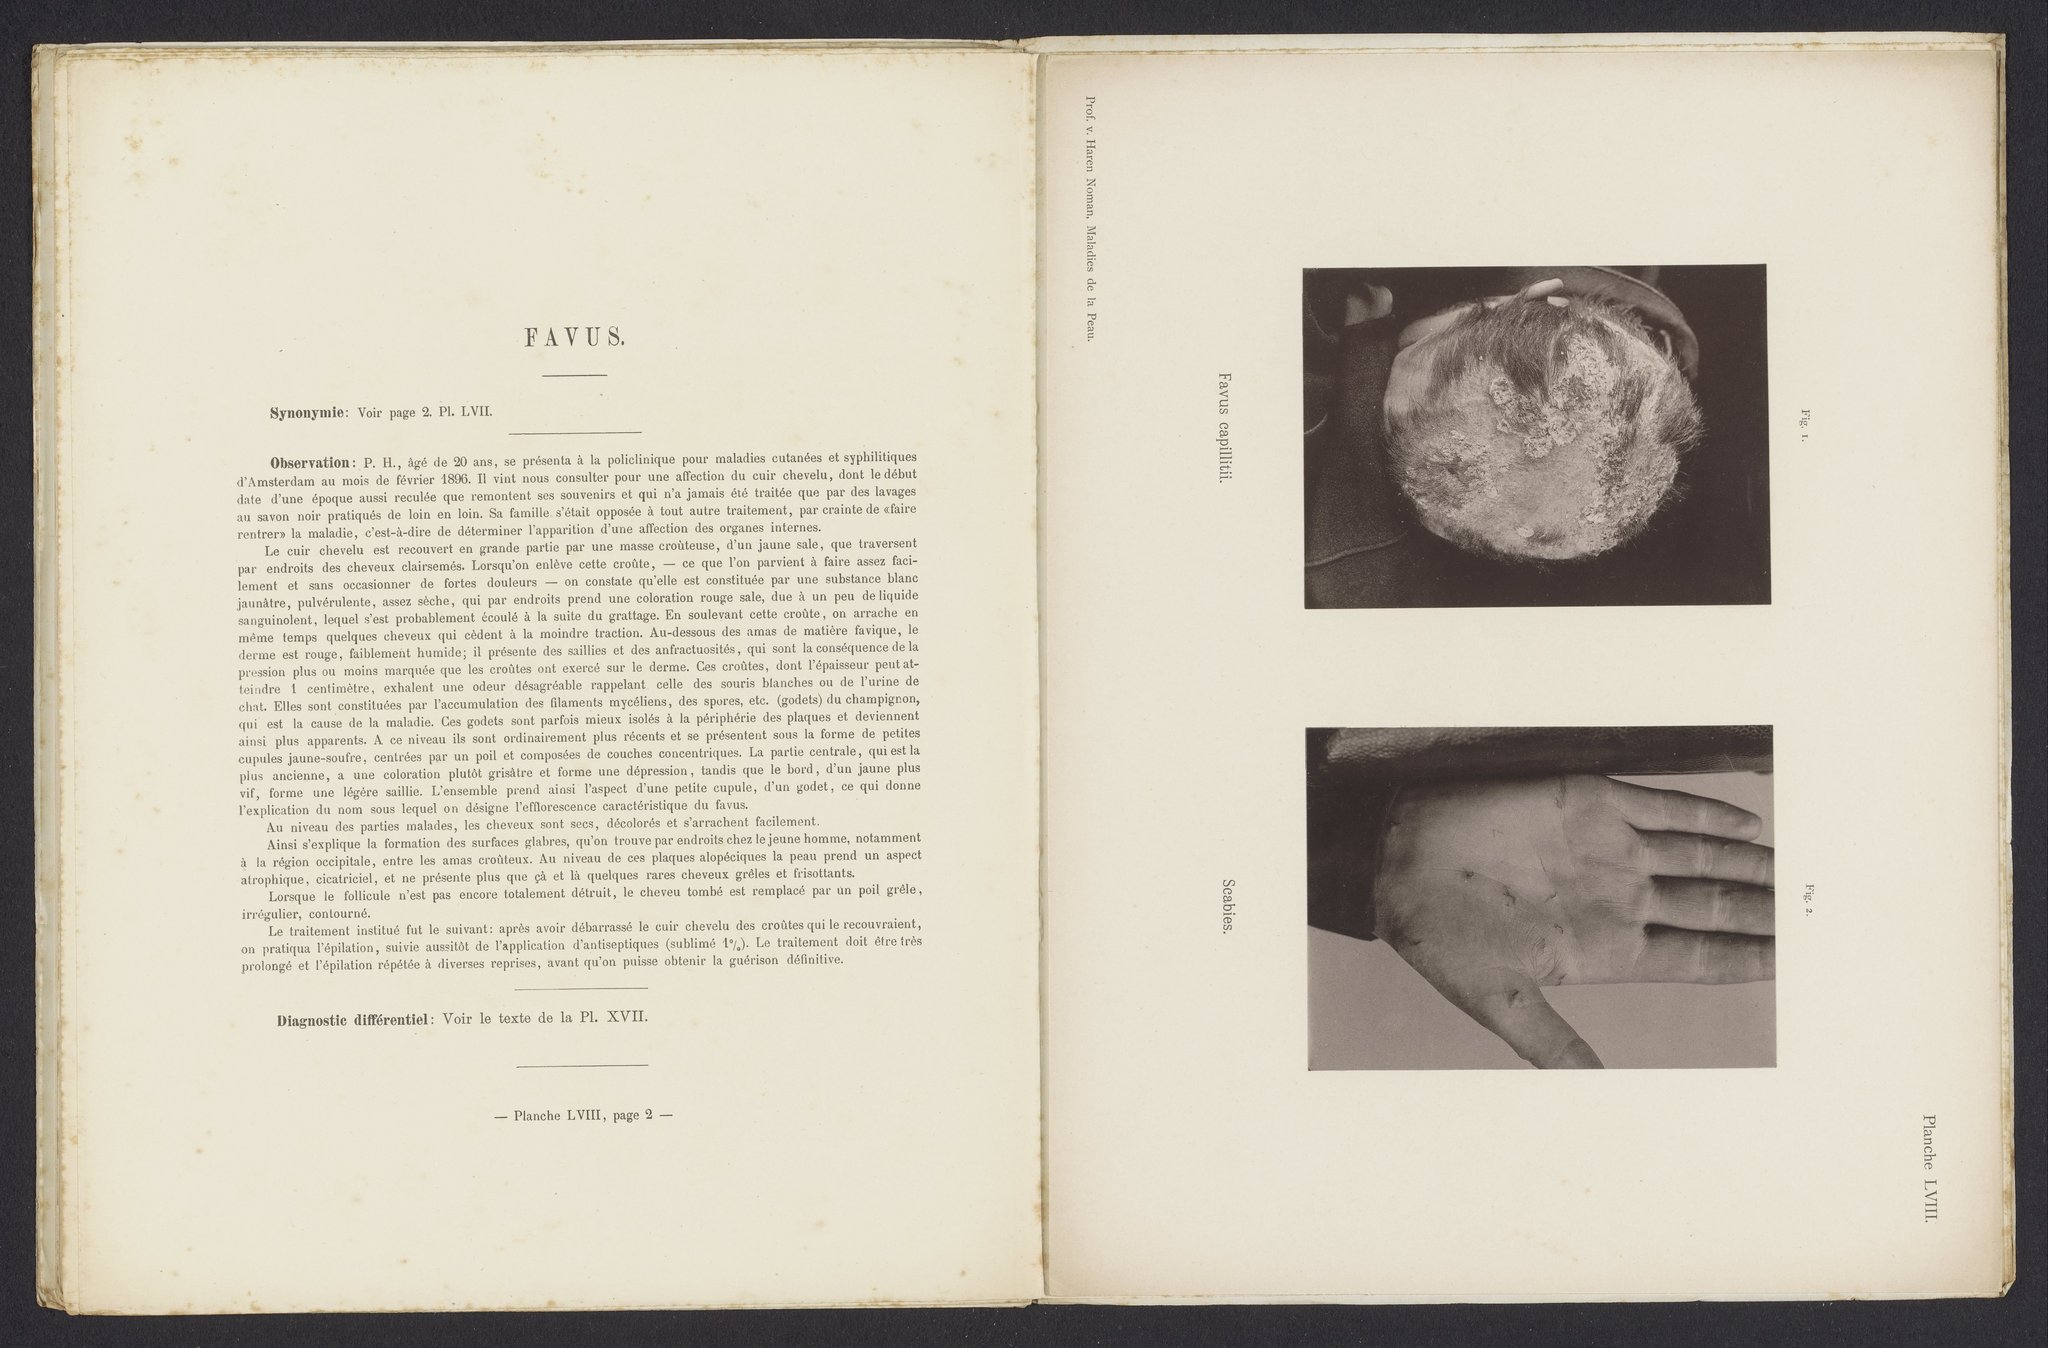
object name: page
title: Scabies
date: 1886-1896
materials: paper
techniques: photograph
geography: haarlem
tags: head (human), skin and venereal diseases, hair, hand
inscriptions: number: ‘Planche LVIII. / Fig. 1. / Fig. 2.’